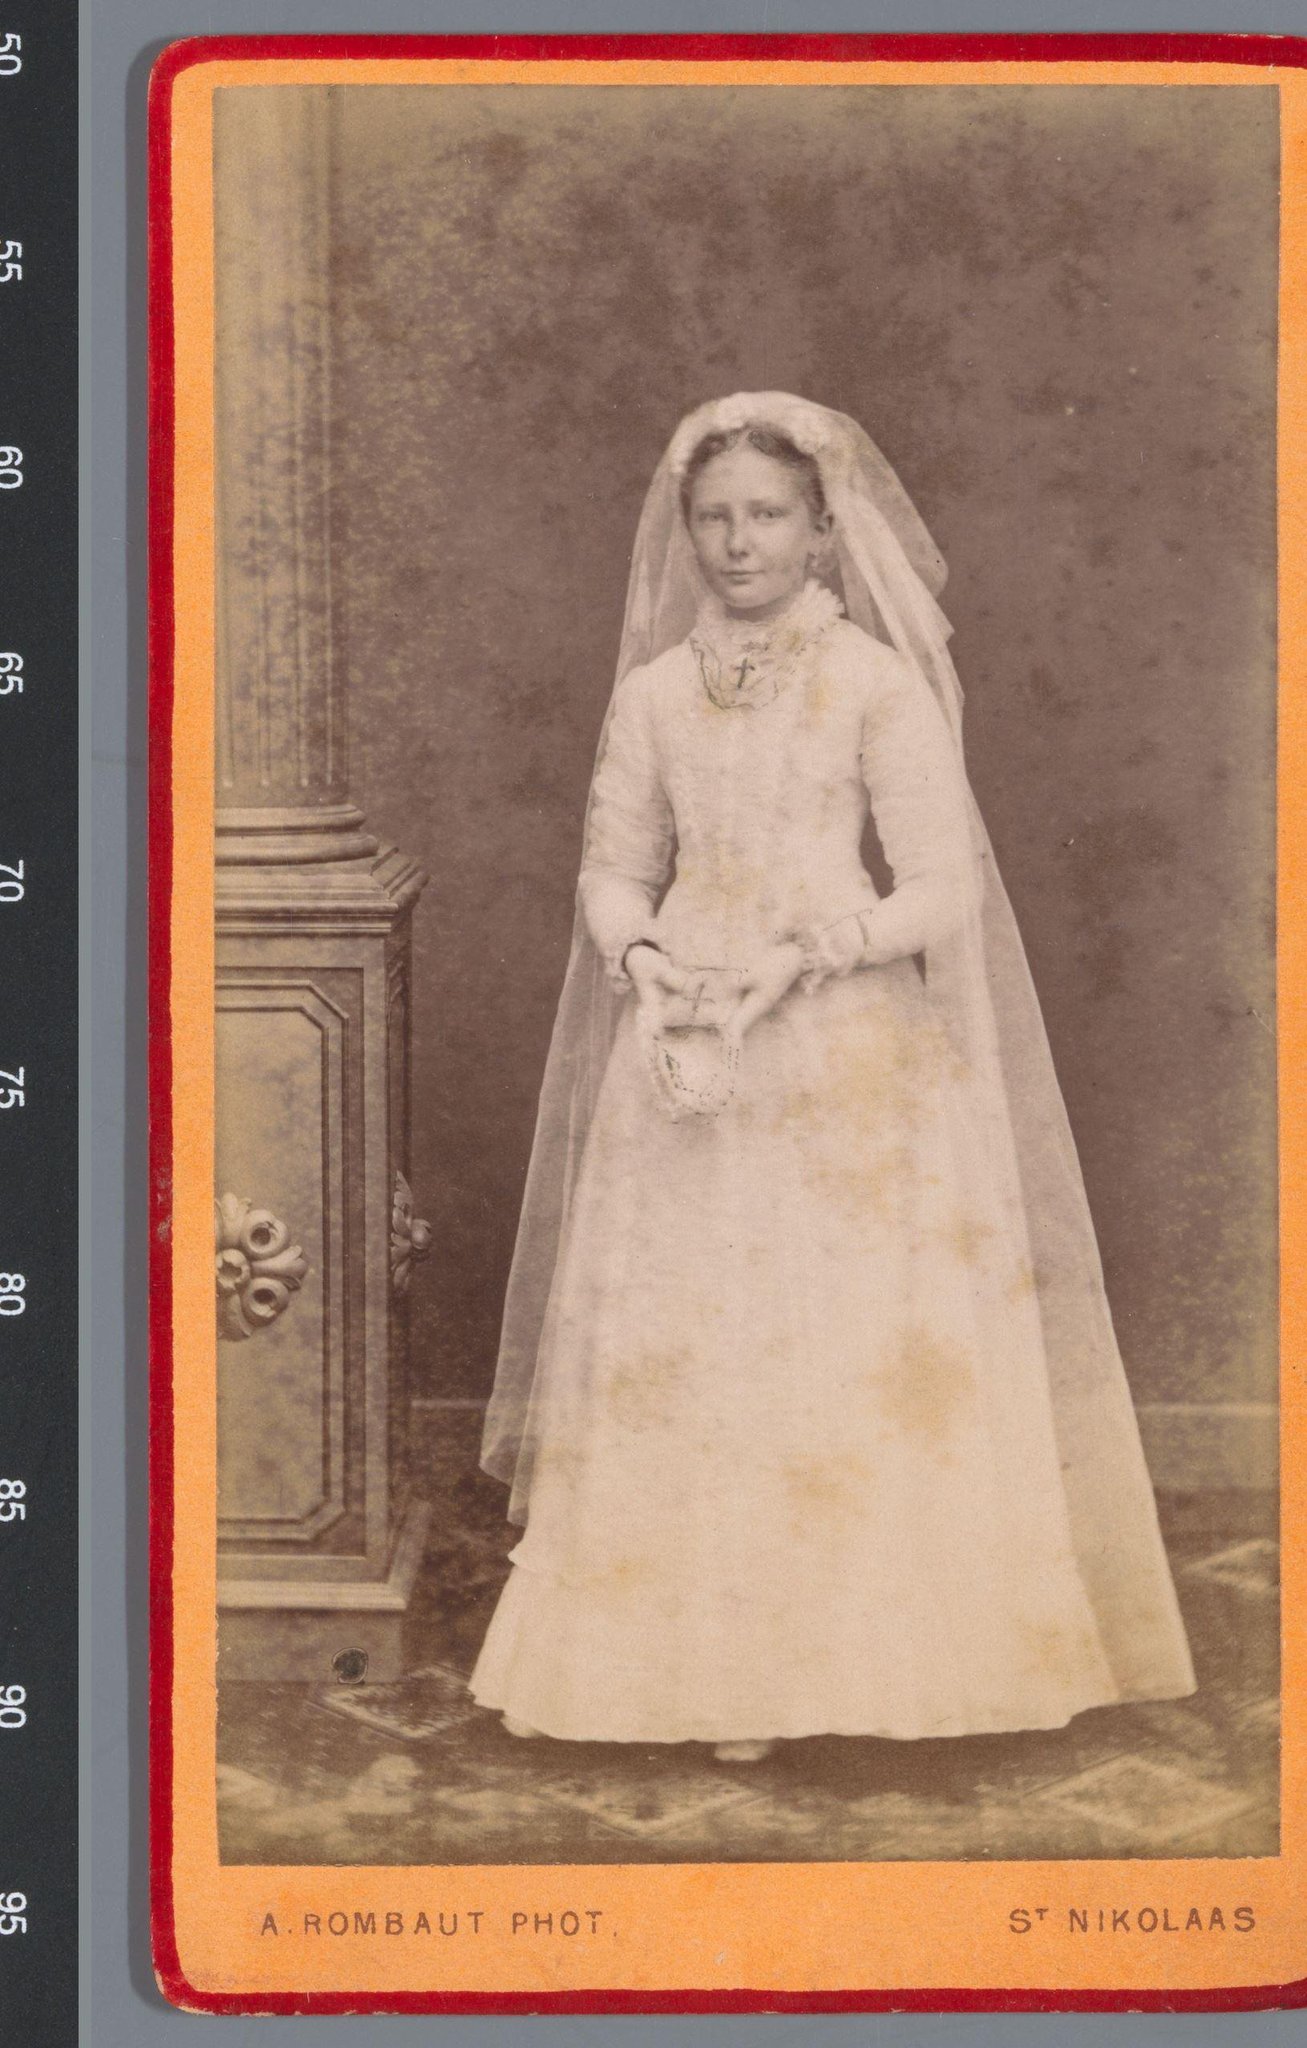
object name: carte de visite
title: Portret van een onbekend meisje, vermoedelijk als communicant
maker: august rombaut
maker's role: fotograaf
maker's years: 1834-1892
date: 1872-1875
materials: cardboard, paper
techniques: albumen print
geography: sint-niklaas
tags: first communicant, historical persons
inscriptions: inscription: ‘PHOTOGRAPHISCHE ATELIER/ VOOR KUNST PORTRETTEN IN ALLE GROOTE/ STAD ST NIKOLAAS/ DIPLOMA/ BEKOMEN DOOR/ August ROMBAUT/ PHOTOGRAPHE/ St. NIKOLAAS/ Nieuwstraat No. 62/ Voor de tentoongestelde Photographien bij het bezoek Hunner Majesteiten den Koning en de Koningin der Belgen den 1ster September 1878/ VOOR NABESTELLINGEN BLIJFT DE PLAAT BEWAARD’